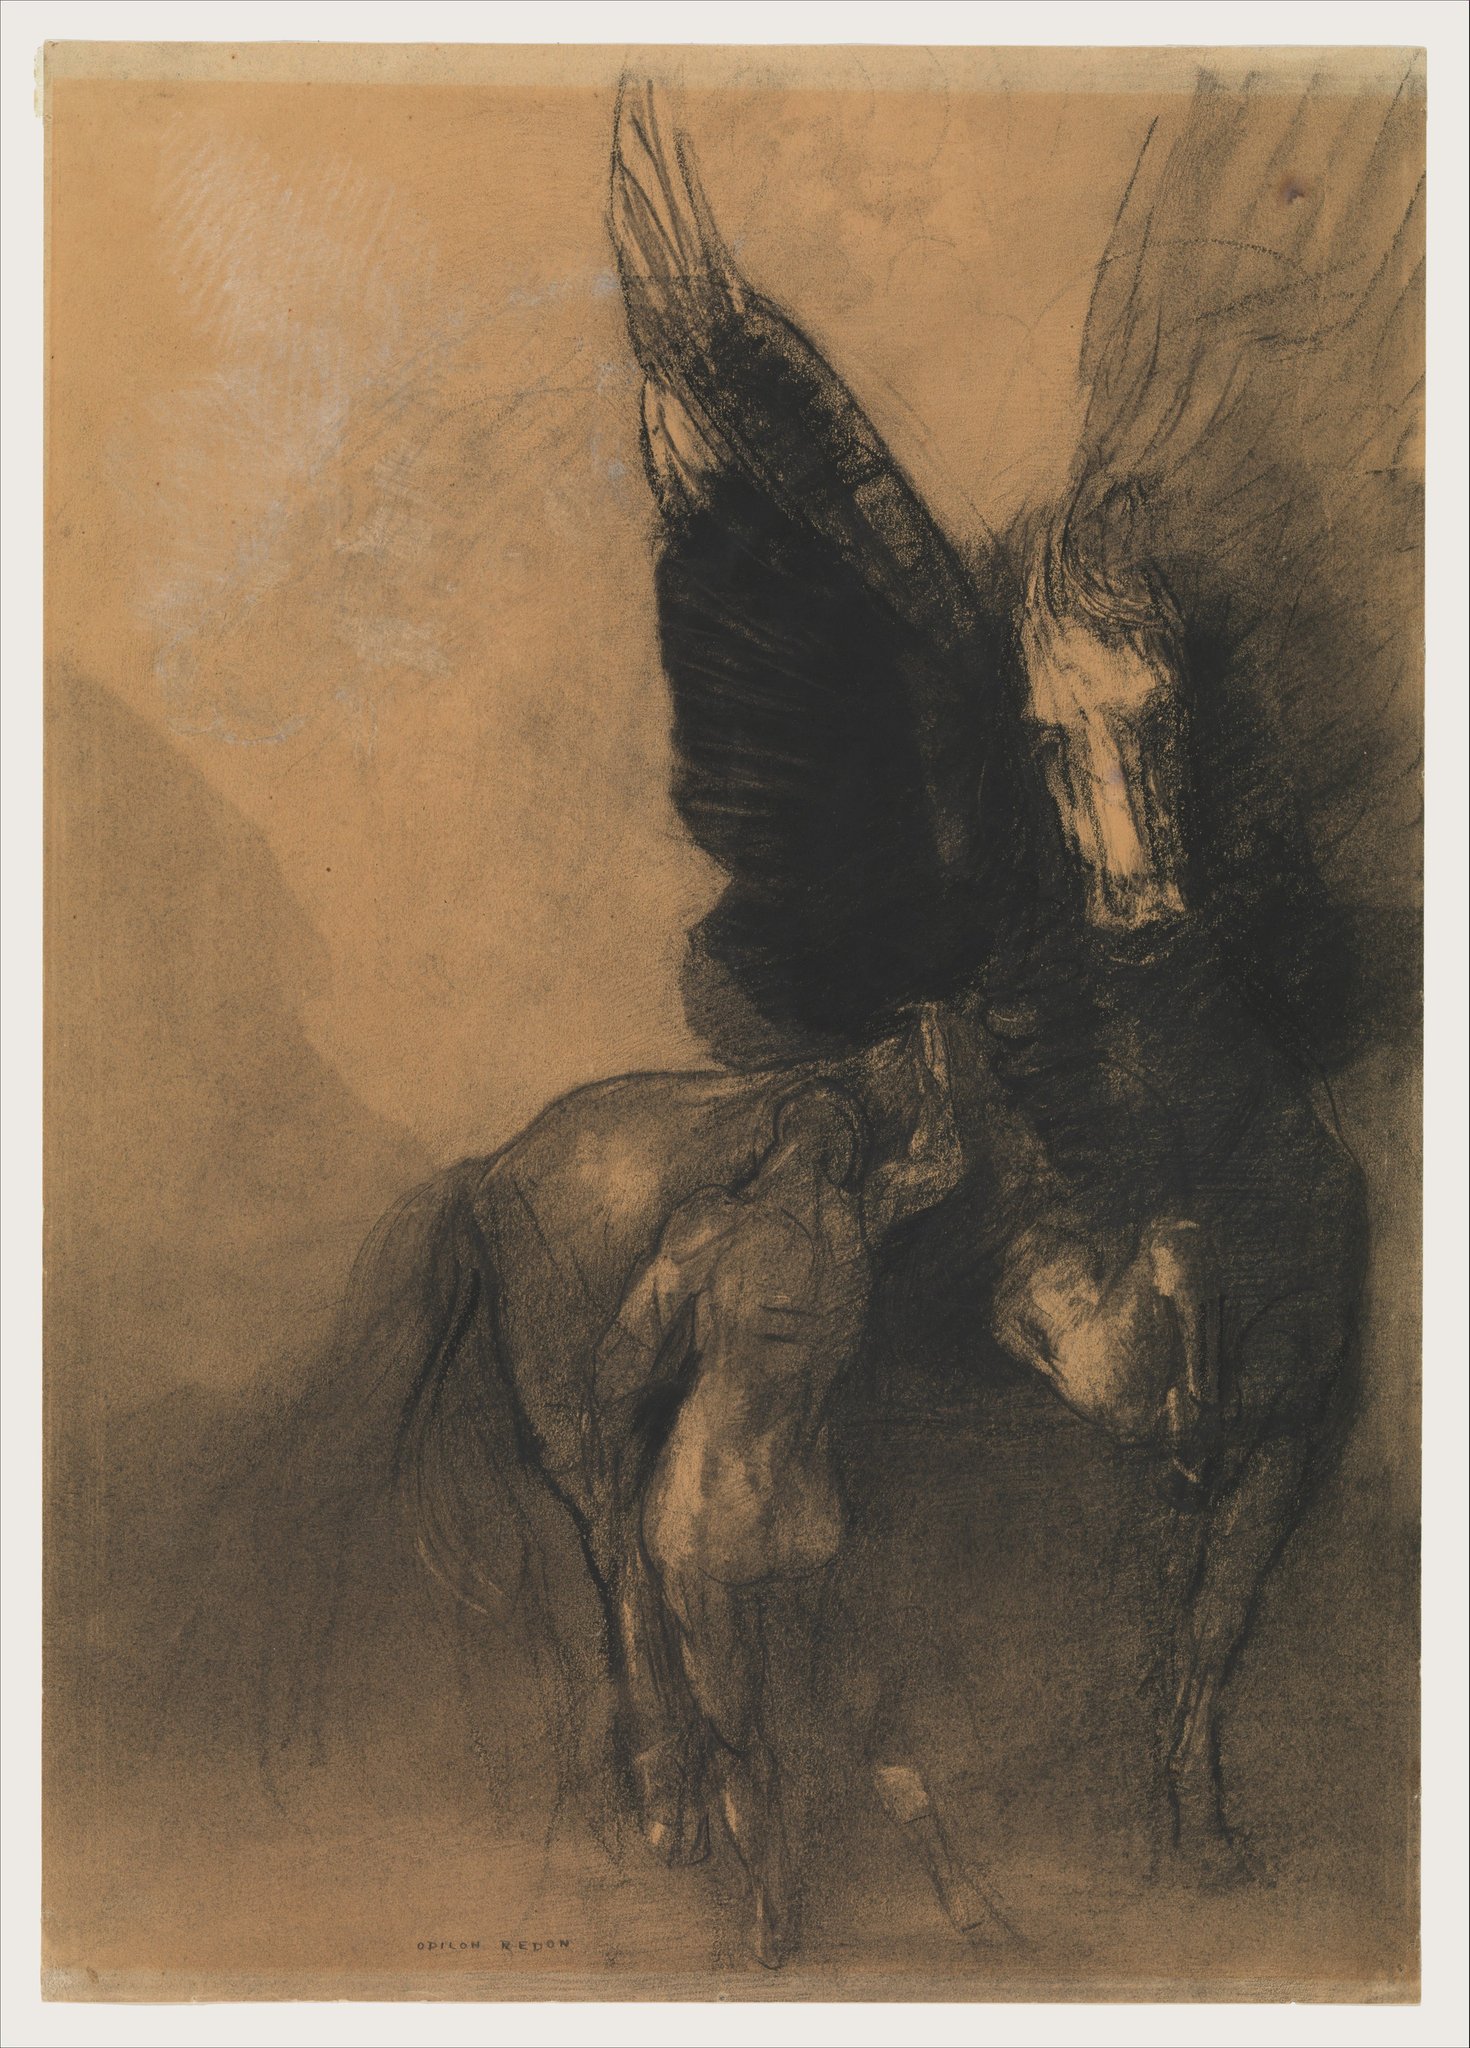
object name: drawing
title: Pegasus and Bellerophon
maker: odilon redon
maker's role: artist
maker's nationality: french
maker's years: 1840-1916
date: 1888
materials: chalk, charcoal, crayon, paper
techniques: wash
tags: men,pegasus